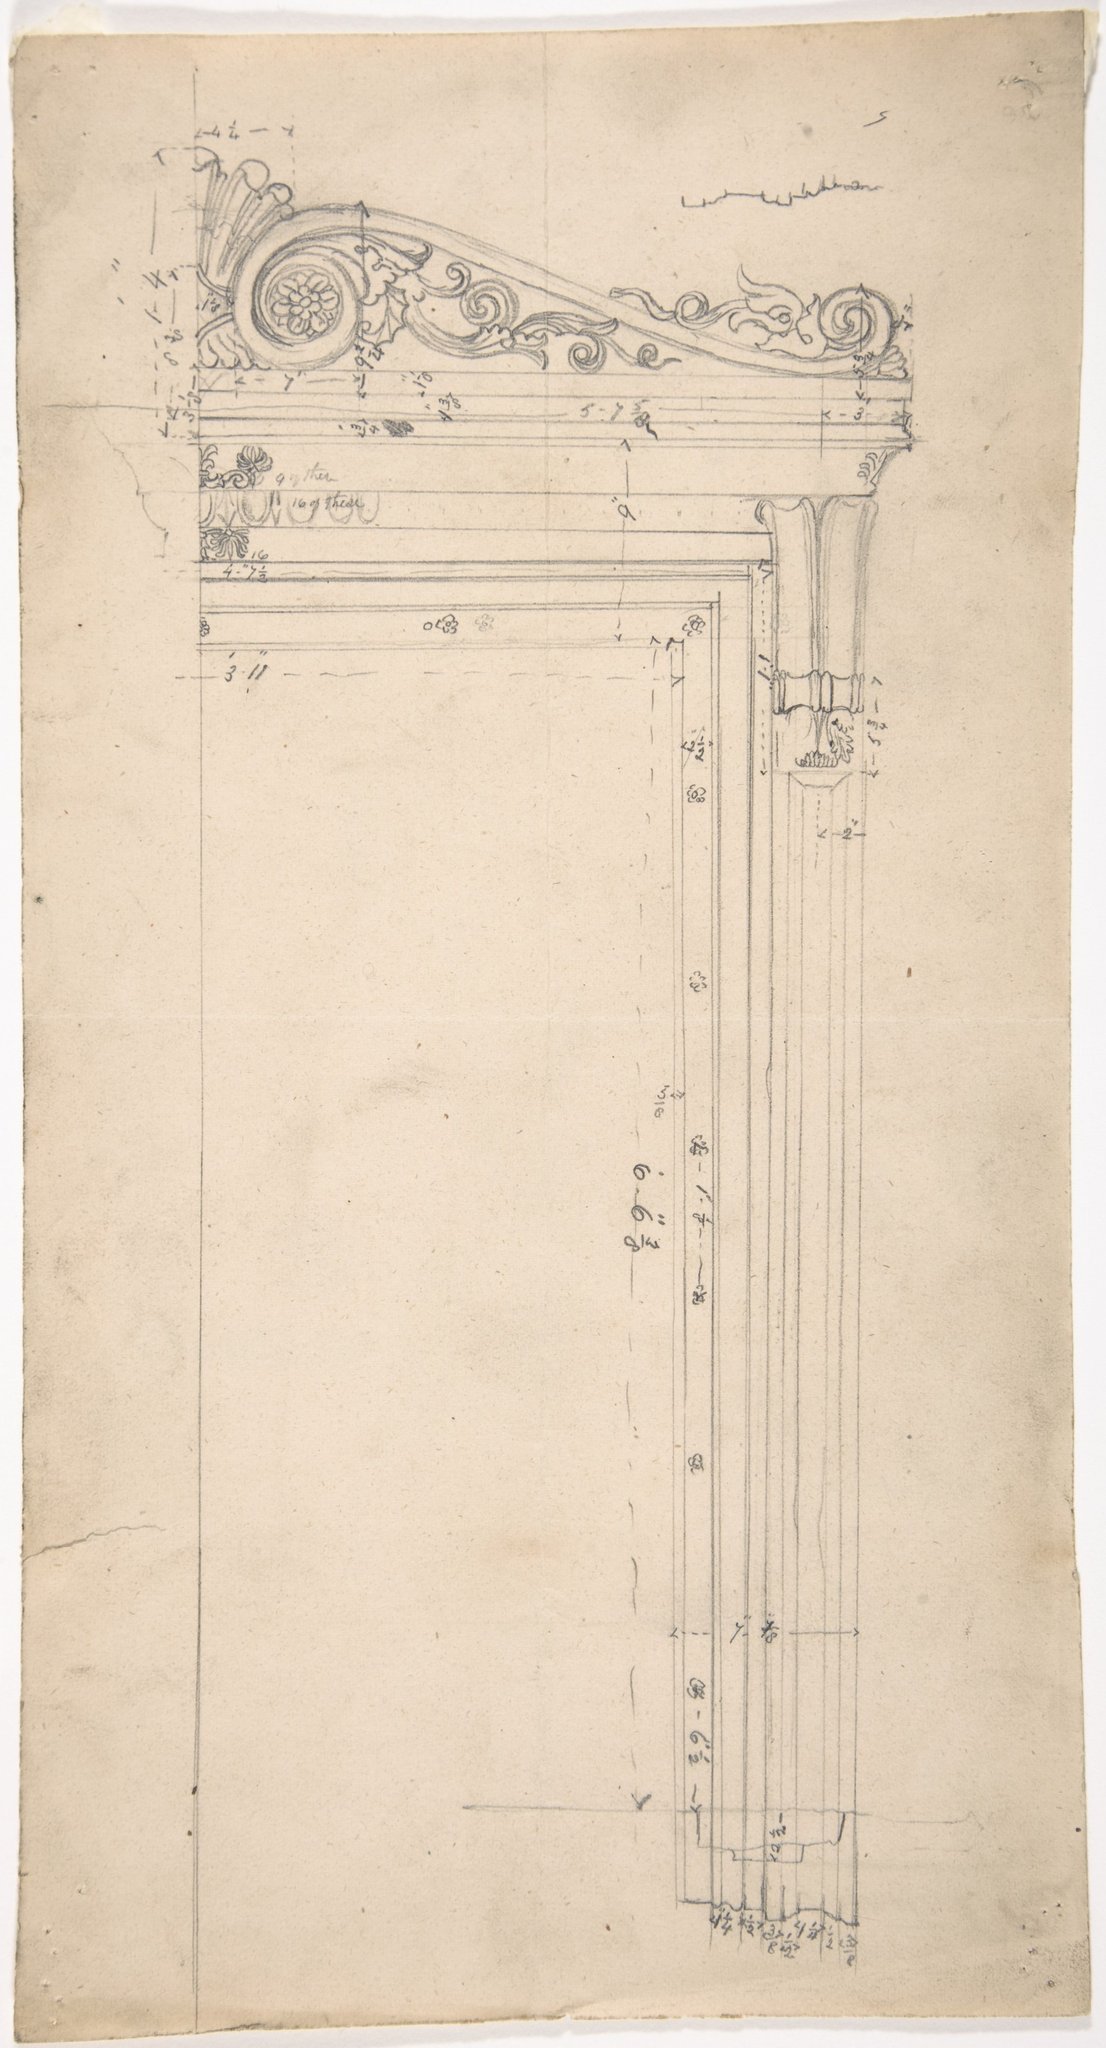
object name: drawing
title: Design for a Door Frame, for 37 Tavistock Place, London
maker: anonymous, british, 19th century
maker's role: artist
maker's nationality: british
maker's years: 1800-1900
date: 1801-1900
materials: graphite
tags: doors